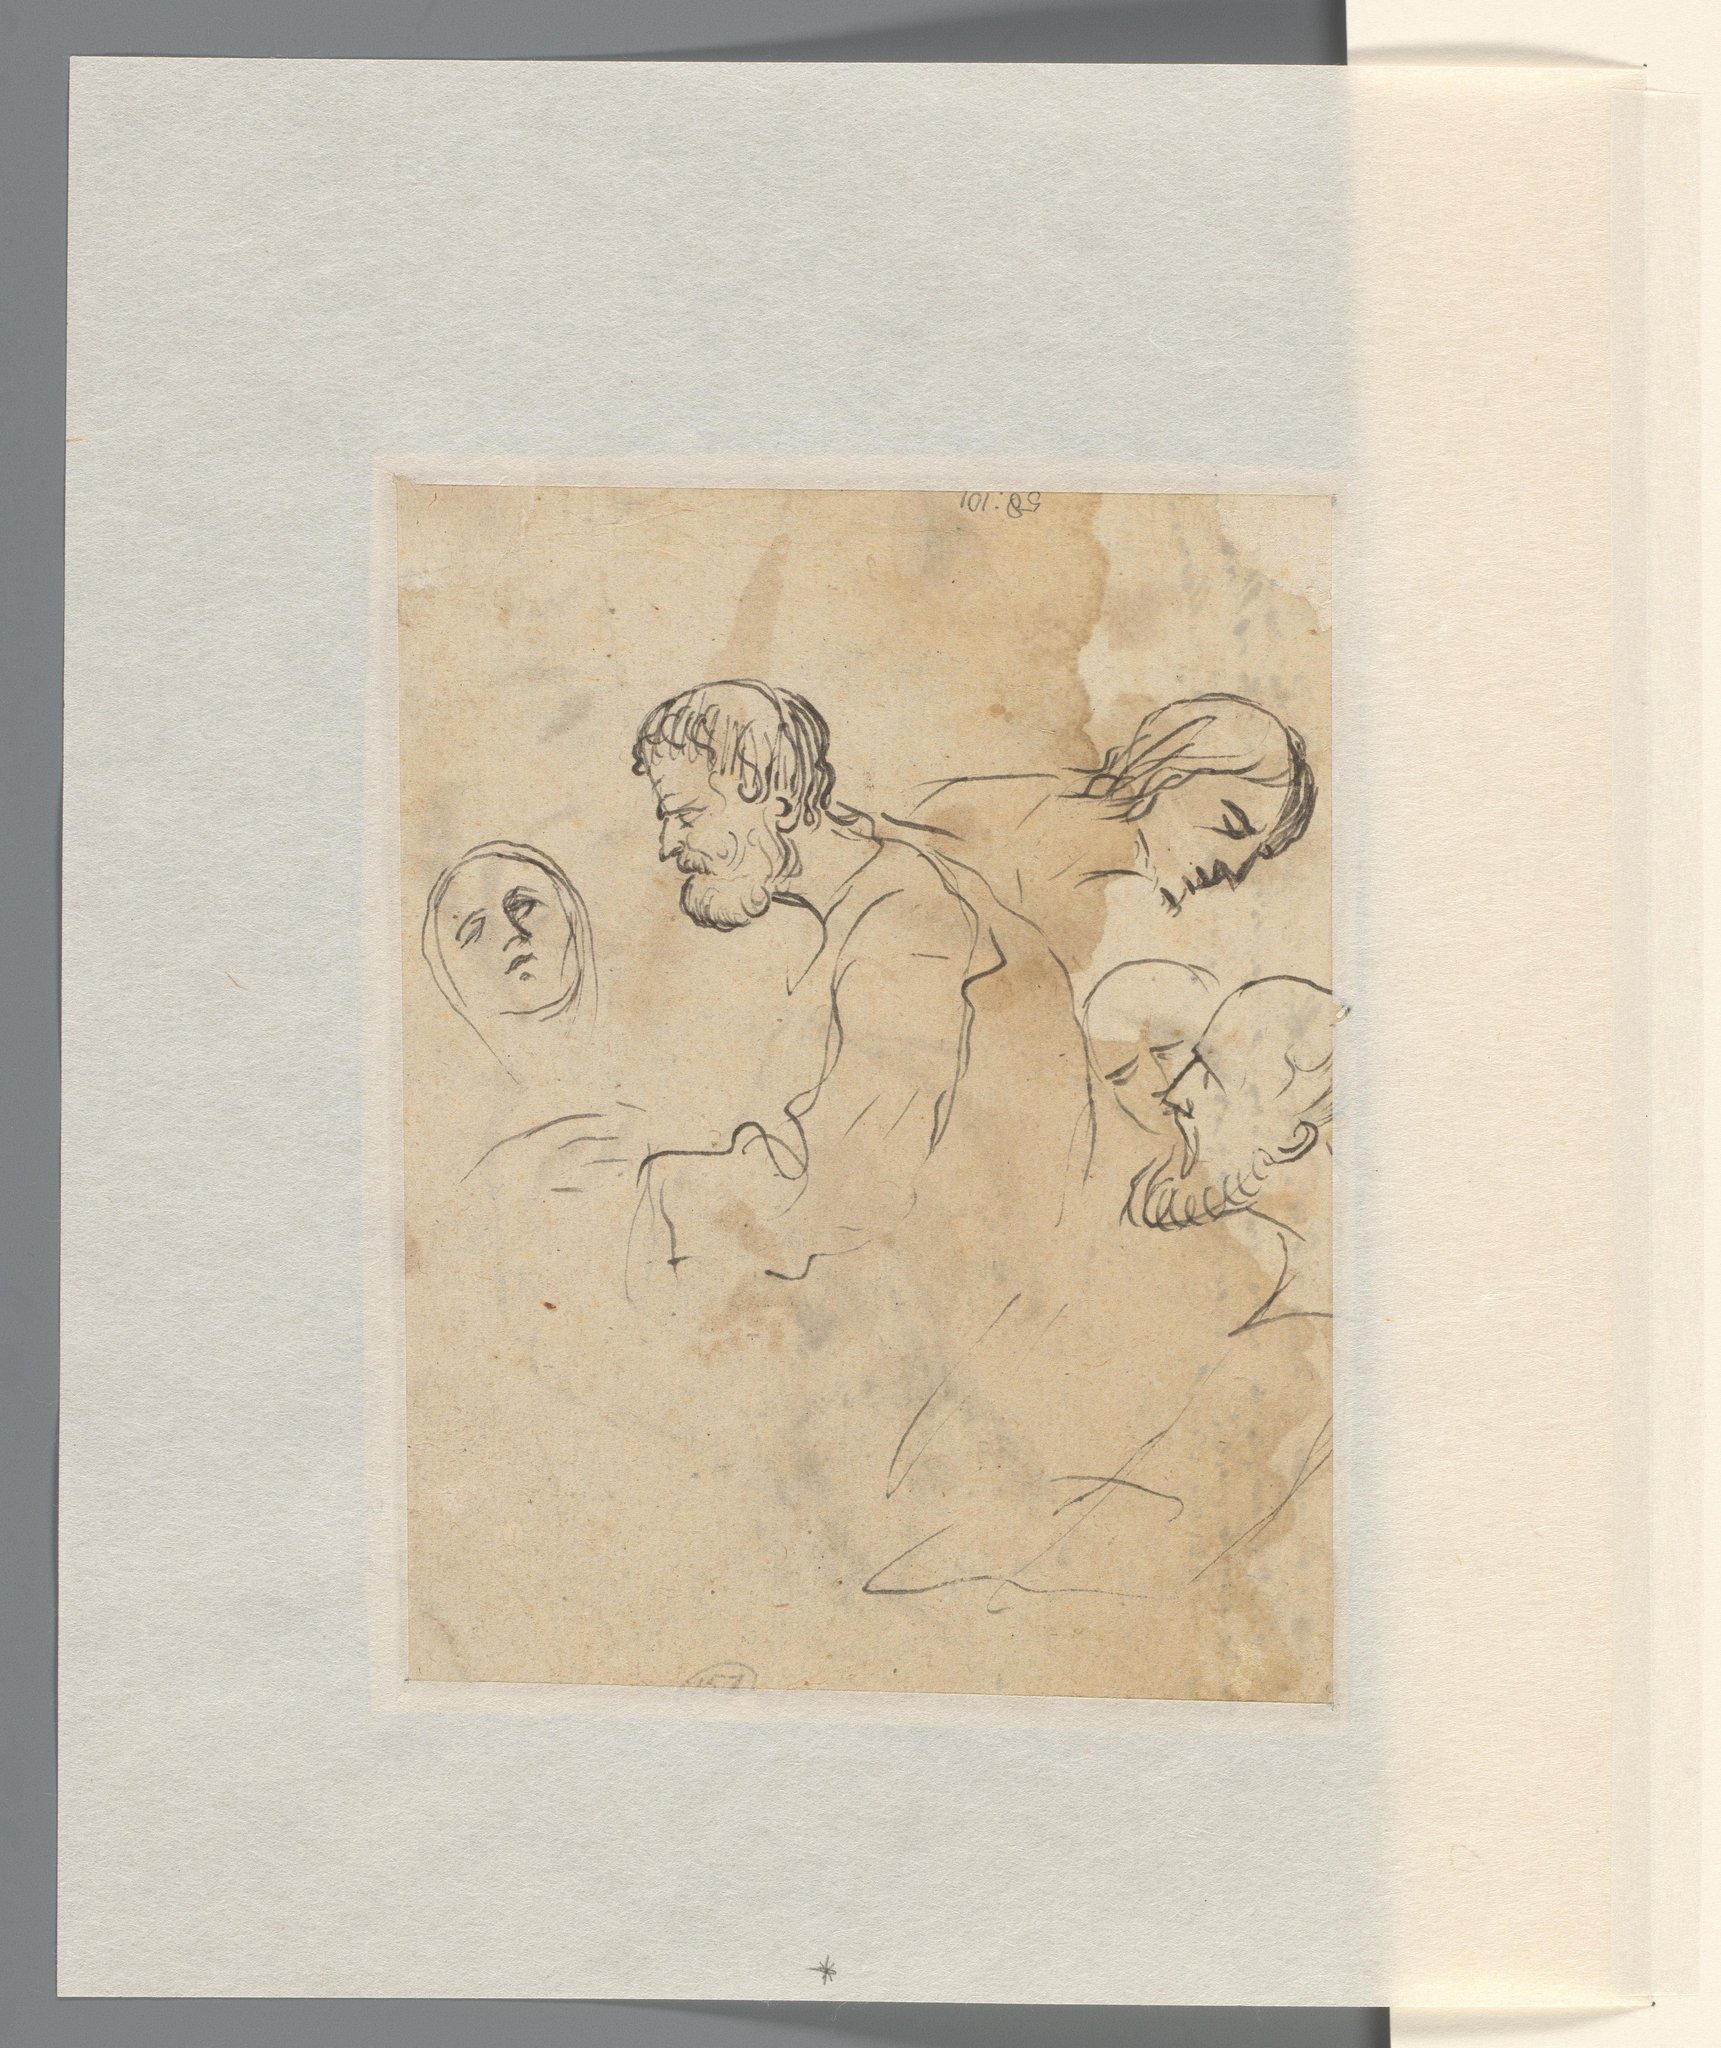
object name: drawing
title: Figuurschetsen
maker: jusepe de ribera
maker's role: draughtsman, painter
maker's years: 1591-1652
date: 1601-1652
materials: ink, paper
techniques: pen